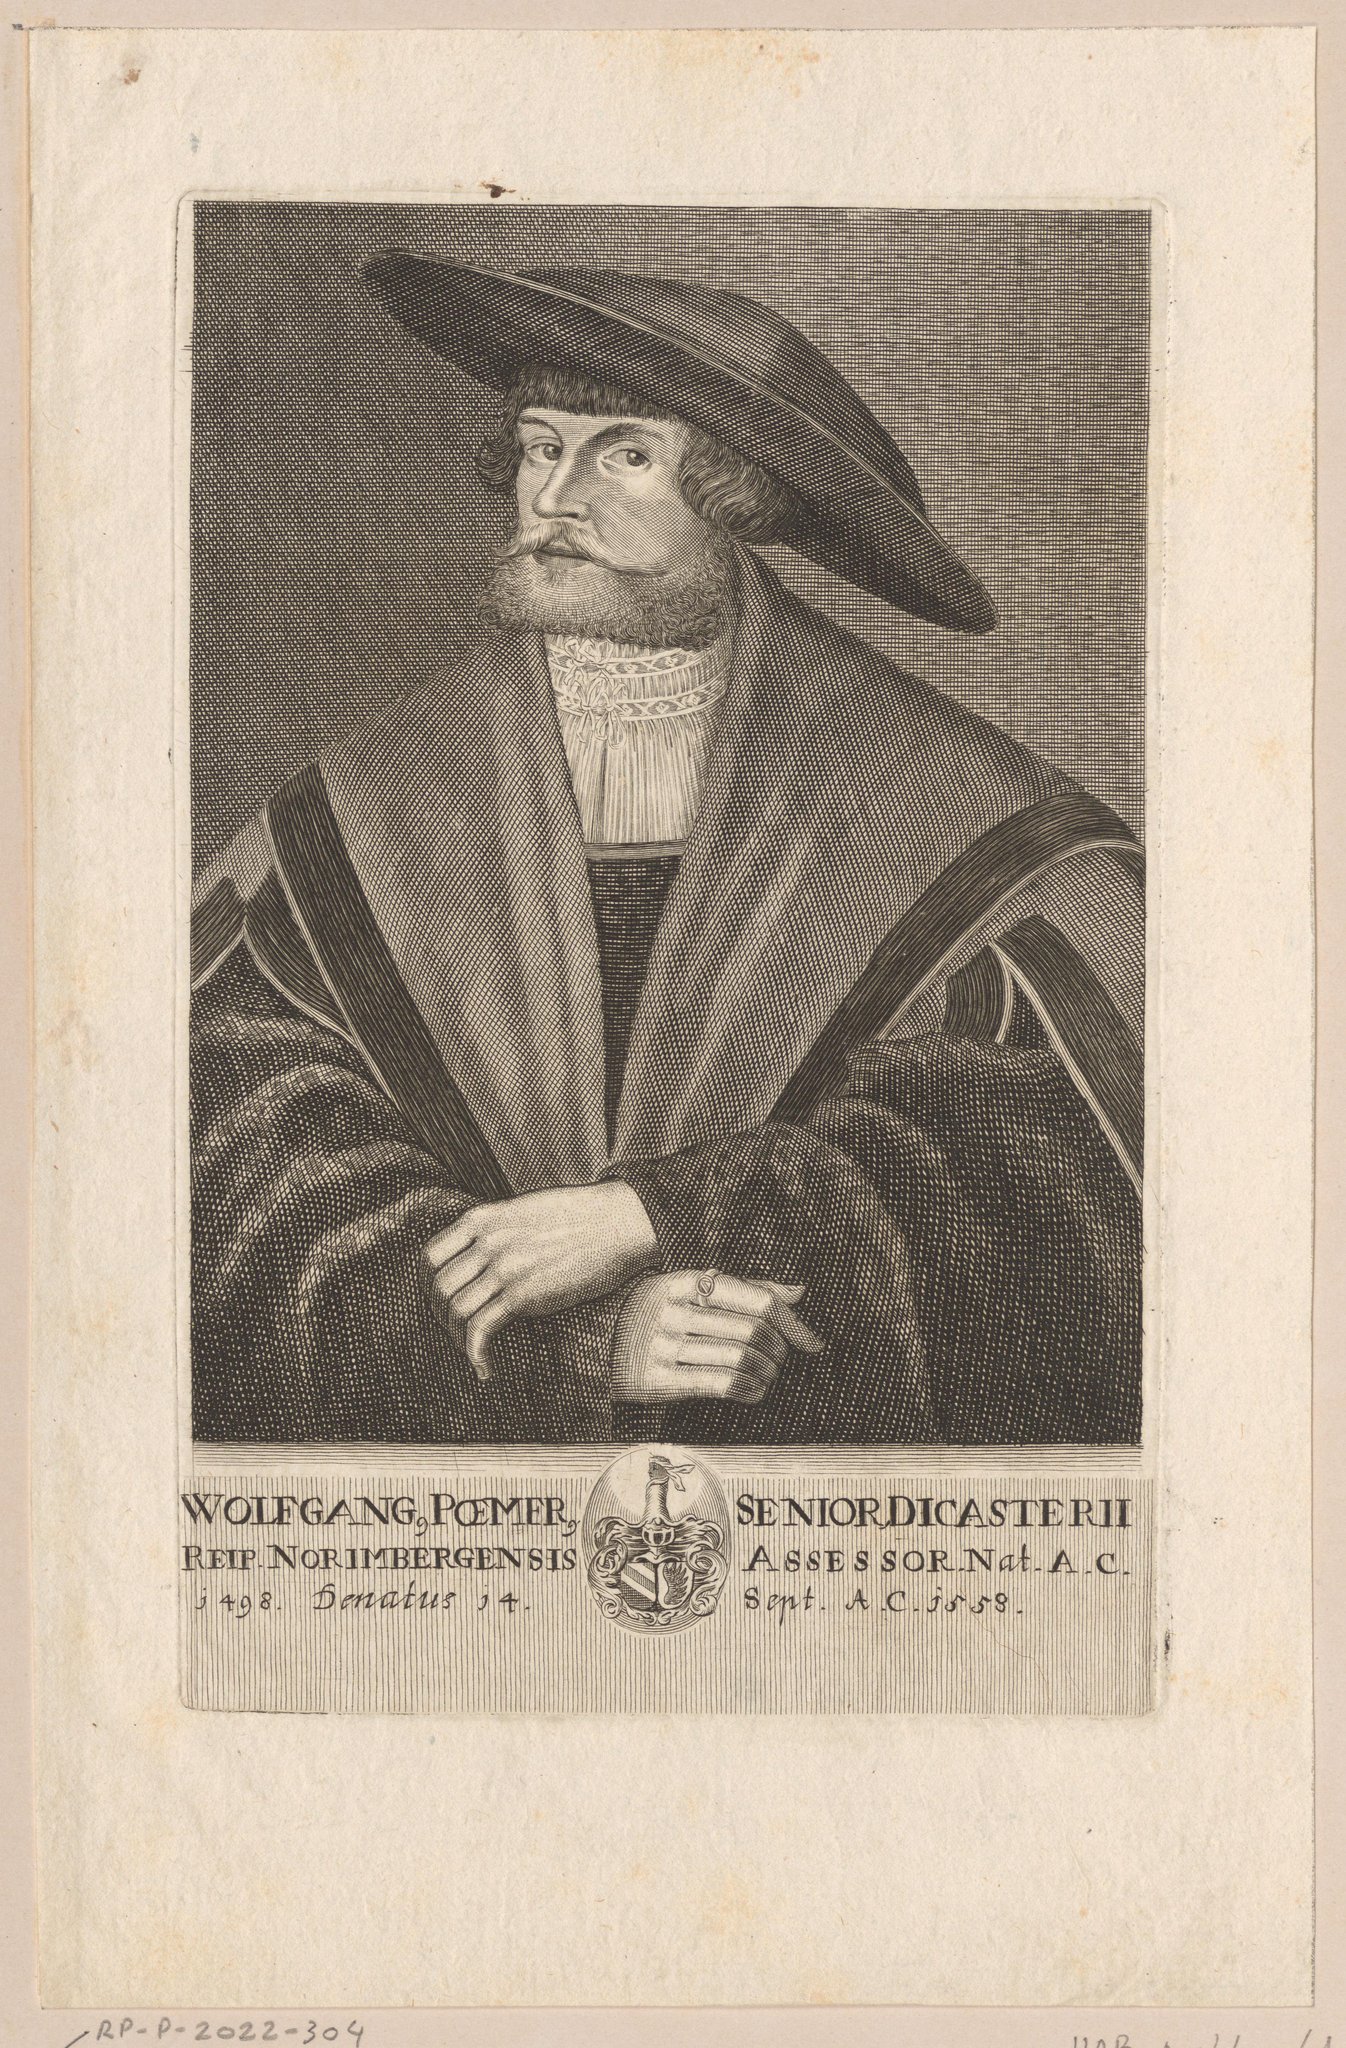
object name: print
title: Portret van Wolff Poemer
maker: Anonymous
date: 1650-1749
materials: paper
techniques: engraving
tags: historical persons, head-gear: hat, armorial bearing, heraldry